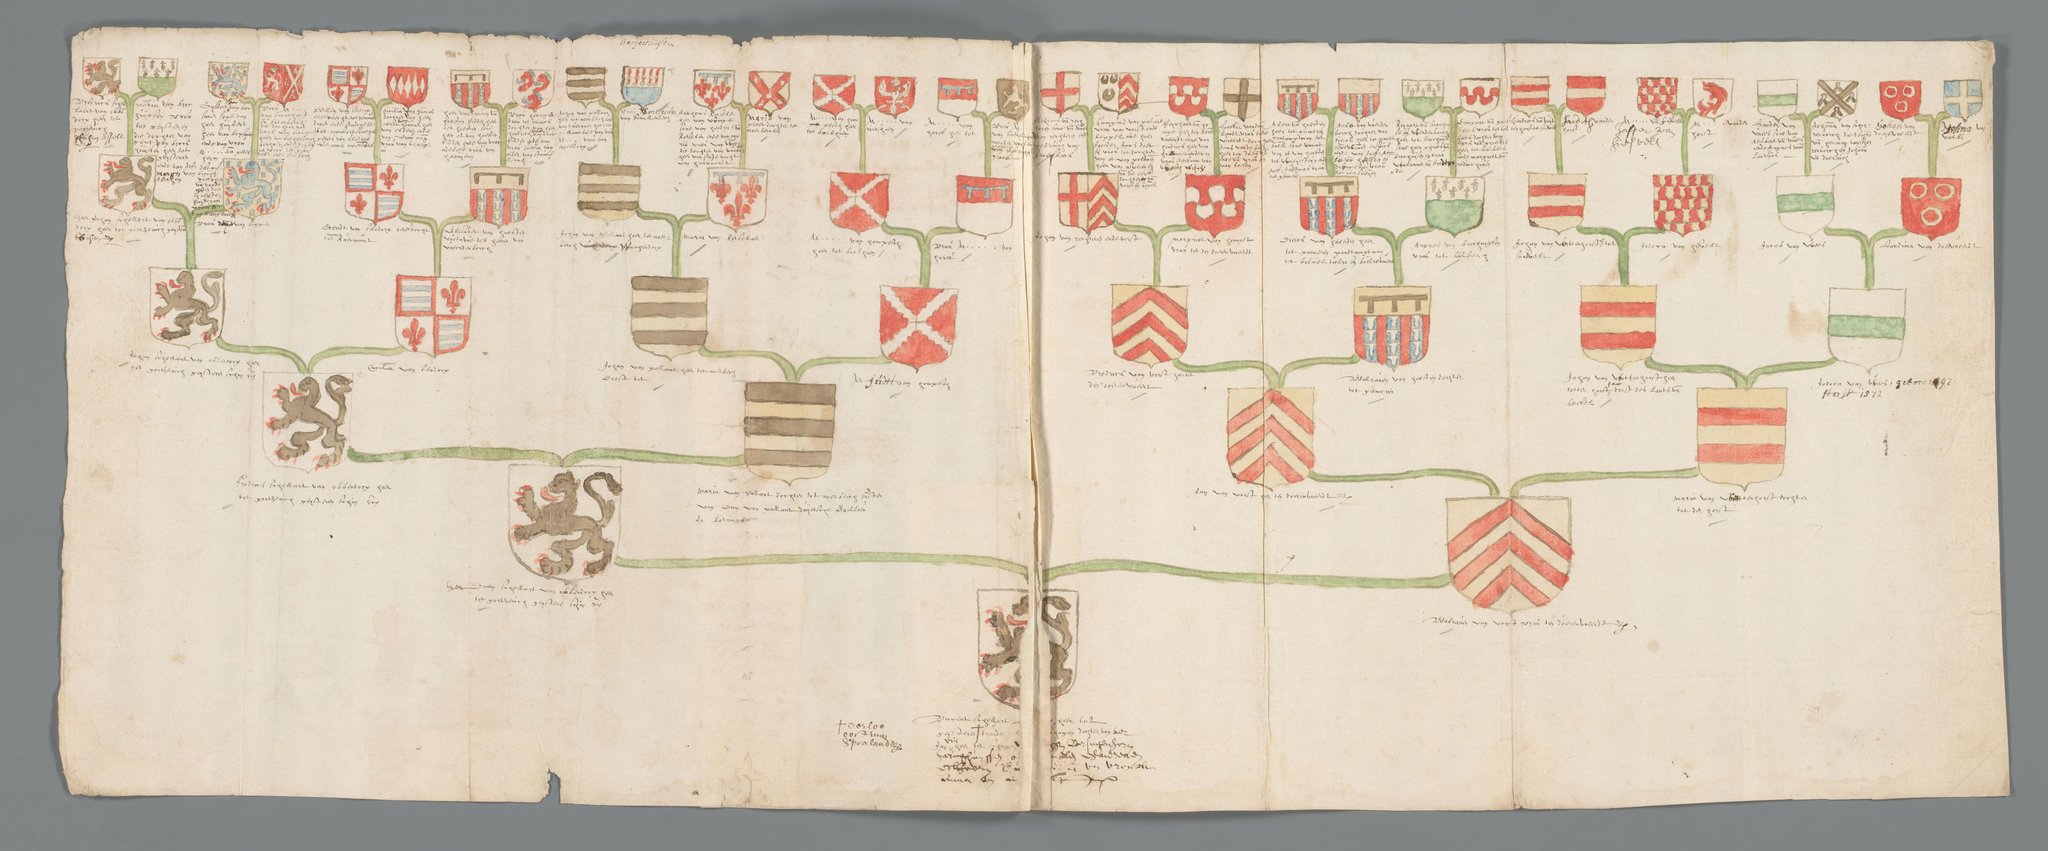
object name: drawing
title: Kwartierstaat van Vincent Schellaert van Obbendorf (1576-1615)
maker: diederik van beieren van schagen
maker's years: 1580-1658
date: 1615-1658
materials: ink, paper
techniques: brush, pen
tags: armorial bearing, heraldry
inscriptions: inscription: ‘32 quartiere van de Heer Vincent van Schellart van/ Obbendorp Heer van geijsteren/ 16 van Schellart en 16 van Voorst’, inscription: ‘dit sijn de xxxij Quartieren van/ myn schoonbroeder die heere/ vincent van schellart Heere van/ Geijsteren Ooerloo oostrum/ ende Spralandt sa[liger]: g: gelyck die/ gesonden syn aen mijn heer vader/ sa[liger]. g. van ons neffve die heere/ tott Haaften Herwijnen etc. en[de]/ die by ons gemelten Neffve/ heere tott Haaften vergadert/ sijn uyt grootten menichten van/ Genealogijen daer hy curieux liefhebber/ van is’